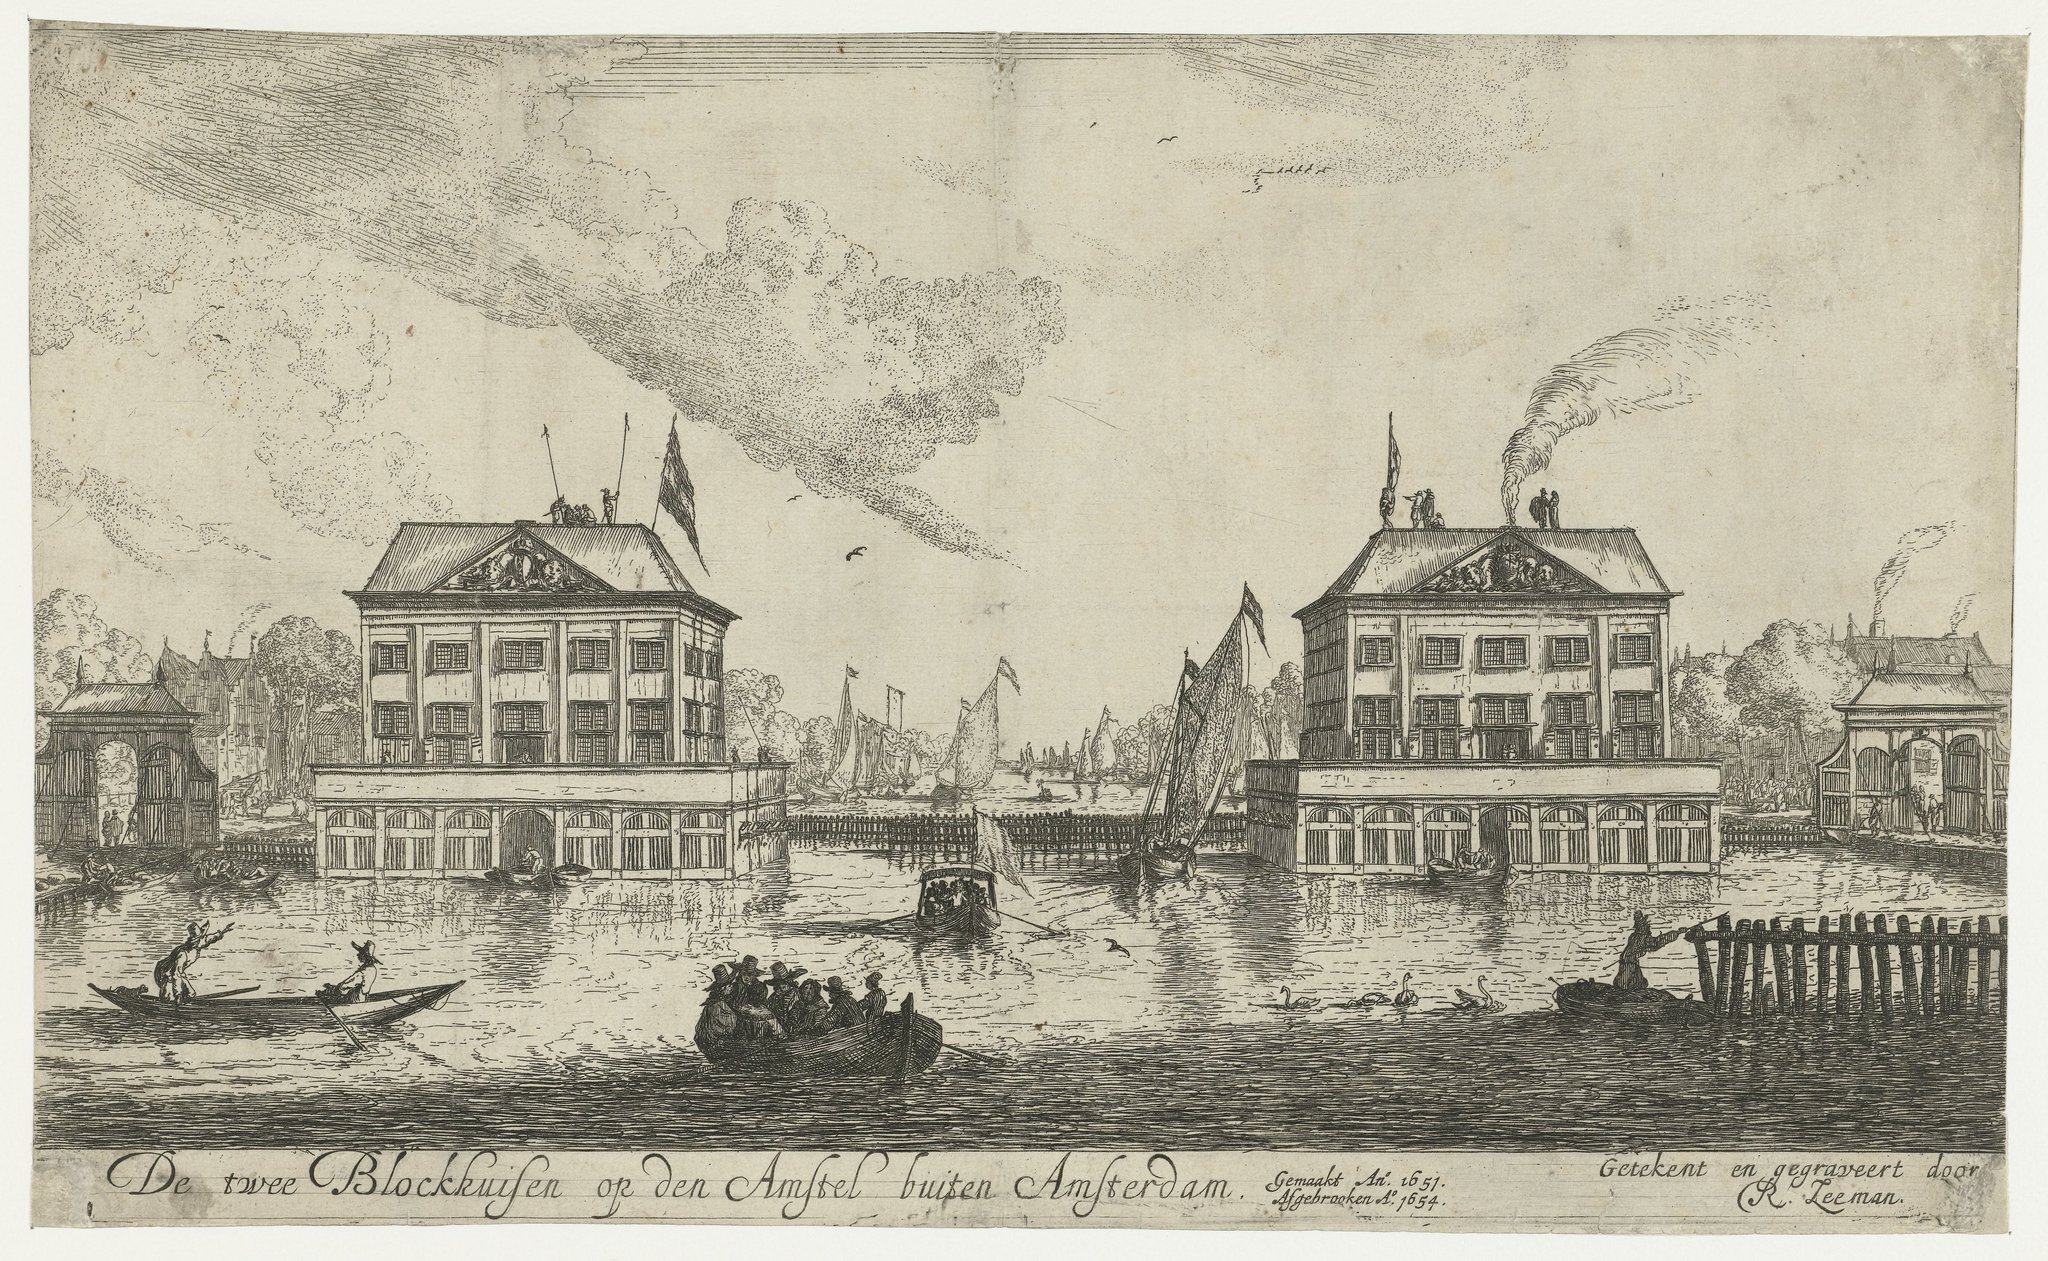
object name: print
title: De twee Blockhuisen op den Amstel buiten Amsterdam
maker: reinier nooms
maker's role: draughtsman, painter, print maker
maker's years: 1623-1664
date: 1651-1654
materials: paper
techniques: etching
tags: city-view in general; 'veduta', amsterdam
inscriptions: collector's mark: Lugt 240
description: De twee blokhuizen op de Amstel. Op het water roeiboten en zeilschepen.